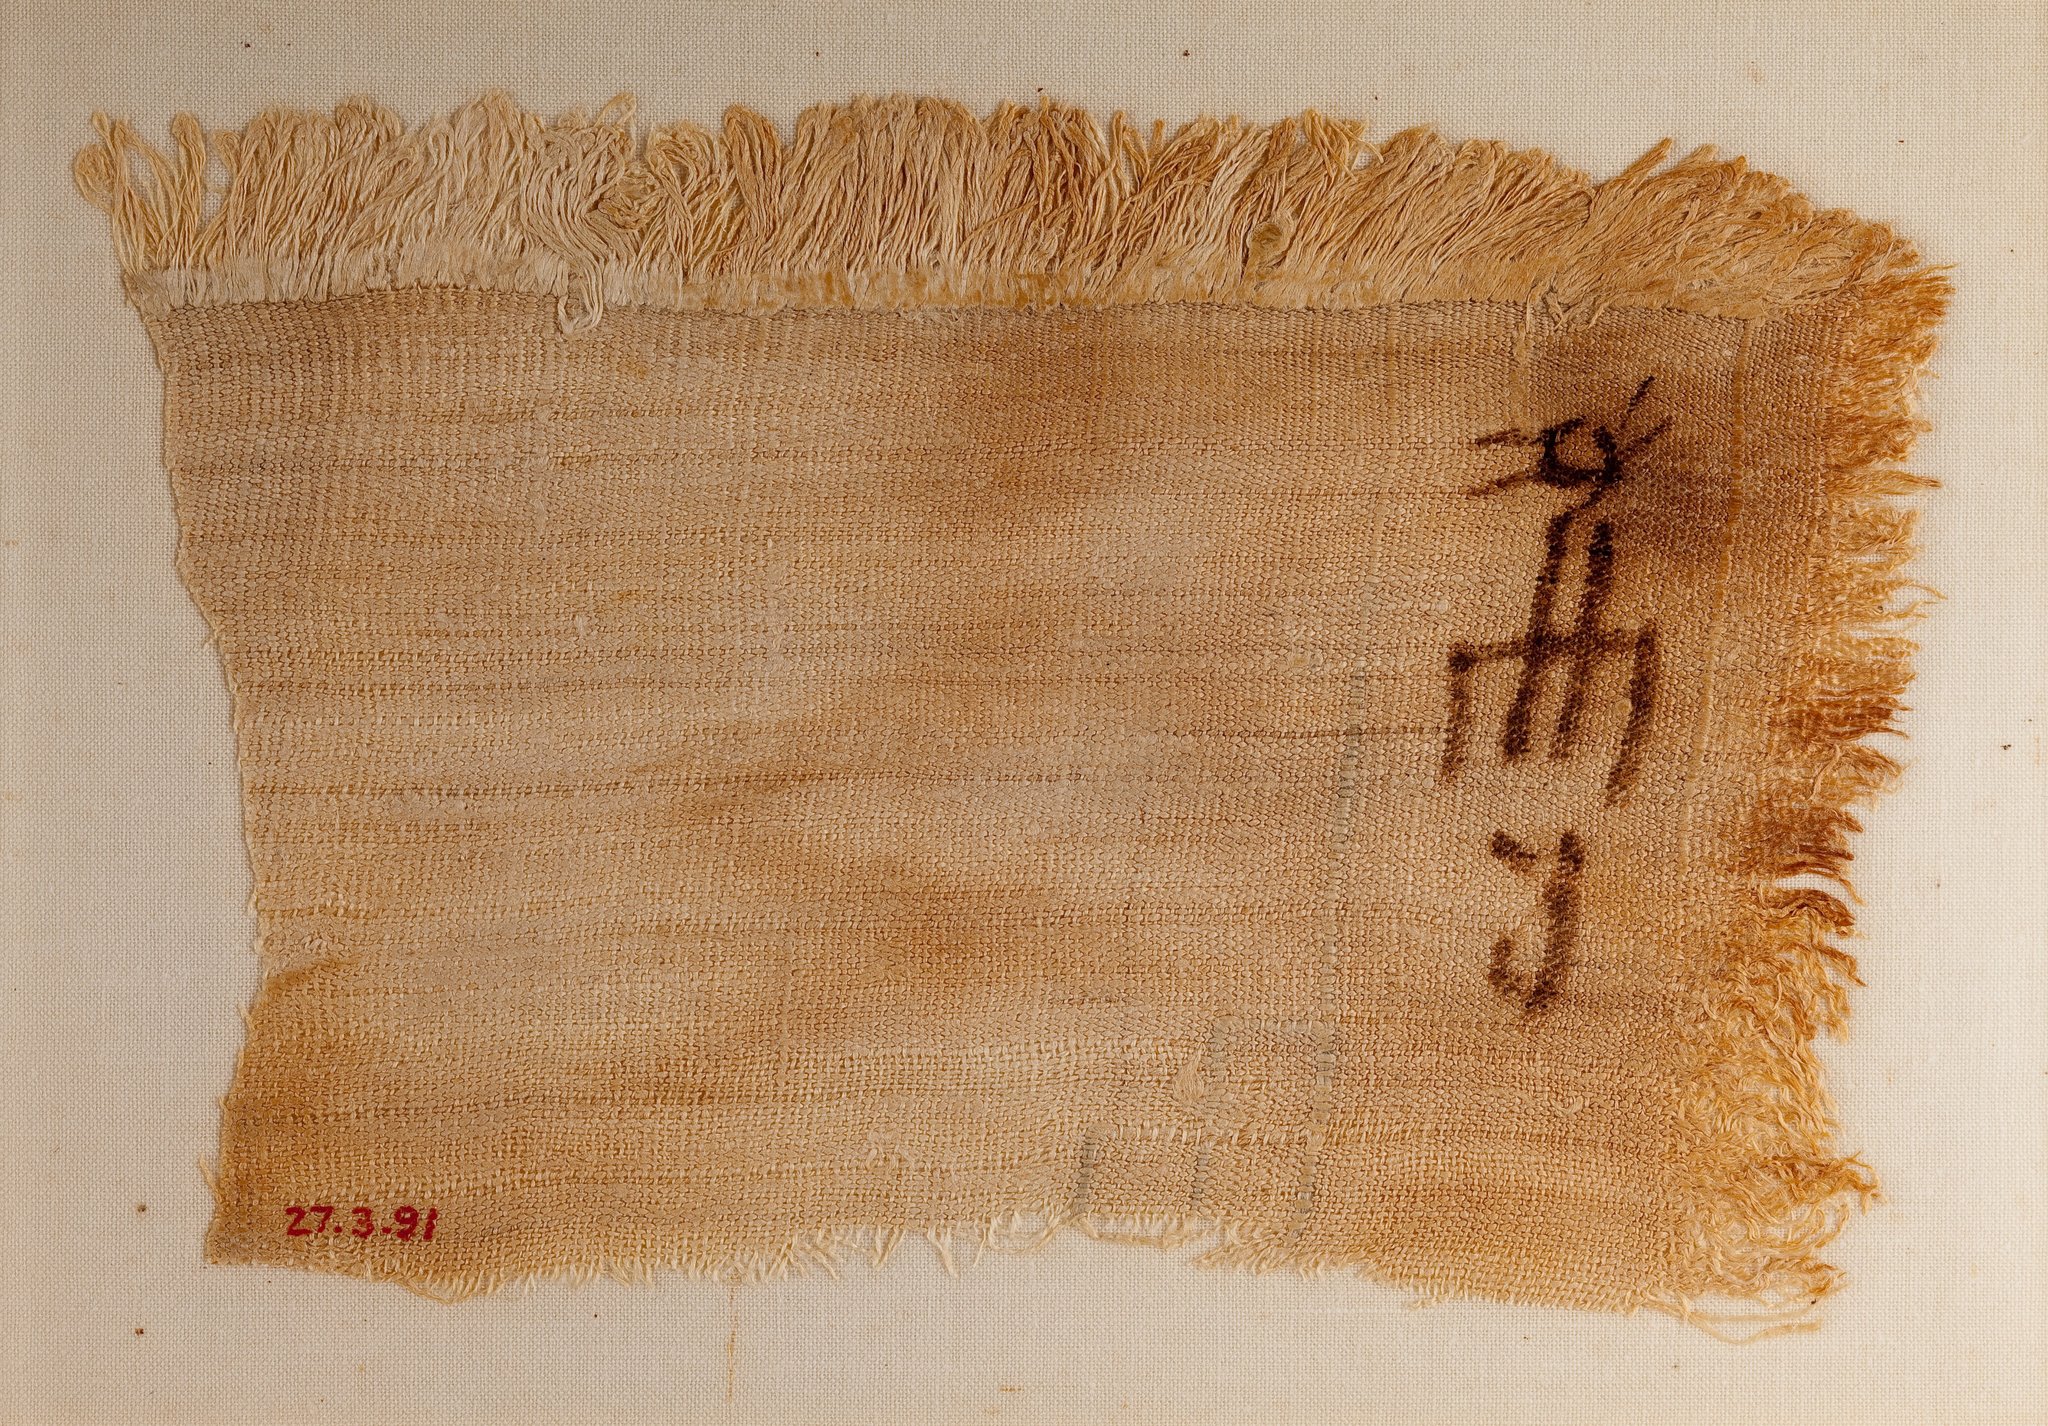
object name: linen mark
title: Linen mark (Type II)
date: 1961-1917 BCE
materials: linen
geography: egypt